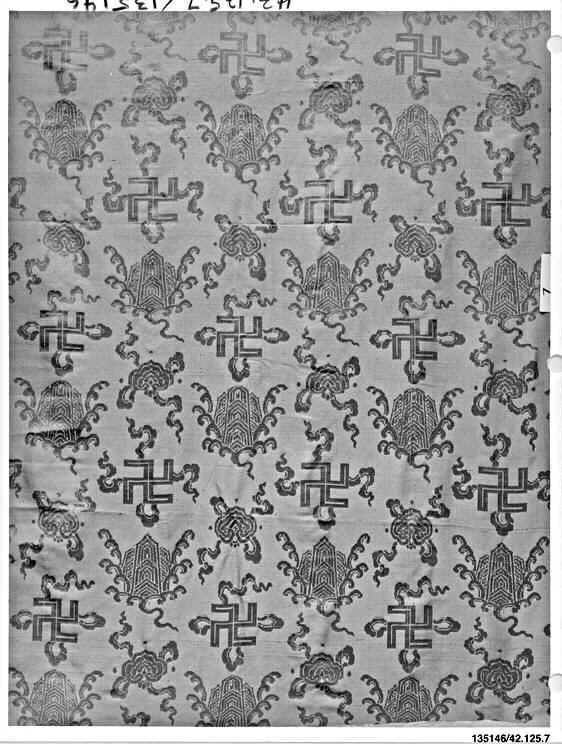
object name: piece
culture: chinese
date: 1801-1900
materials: silk